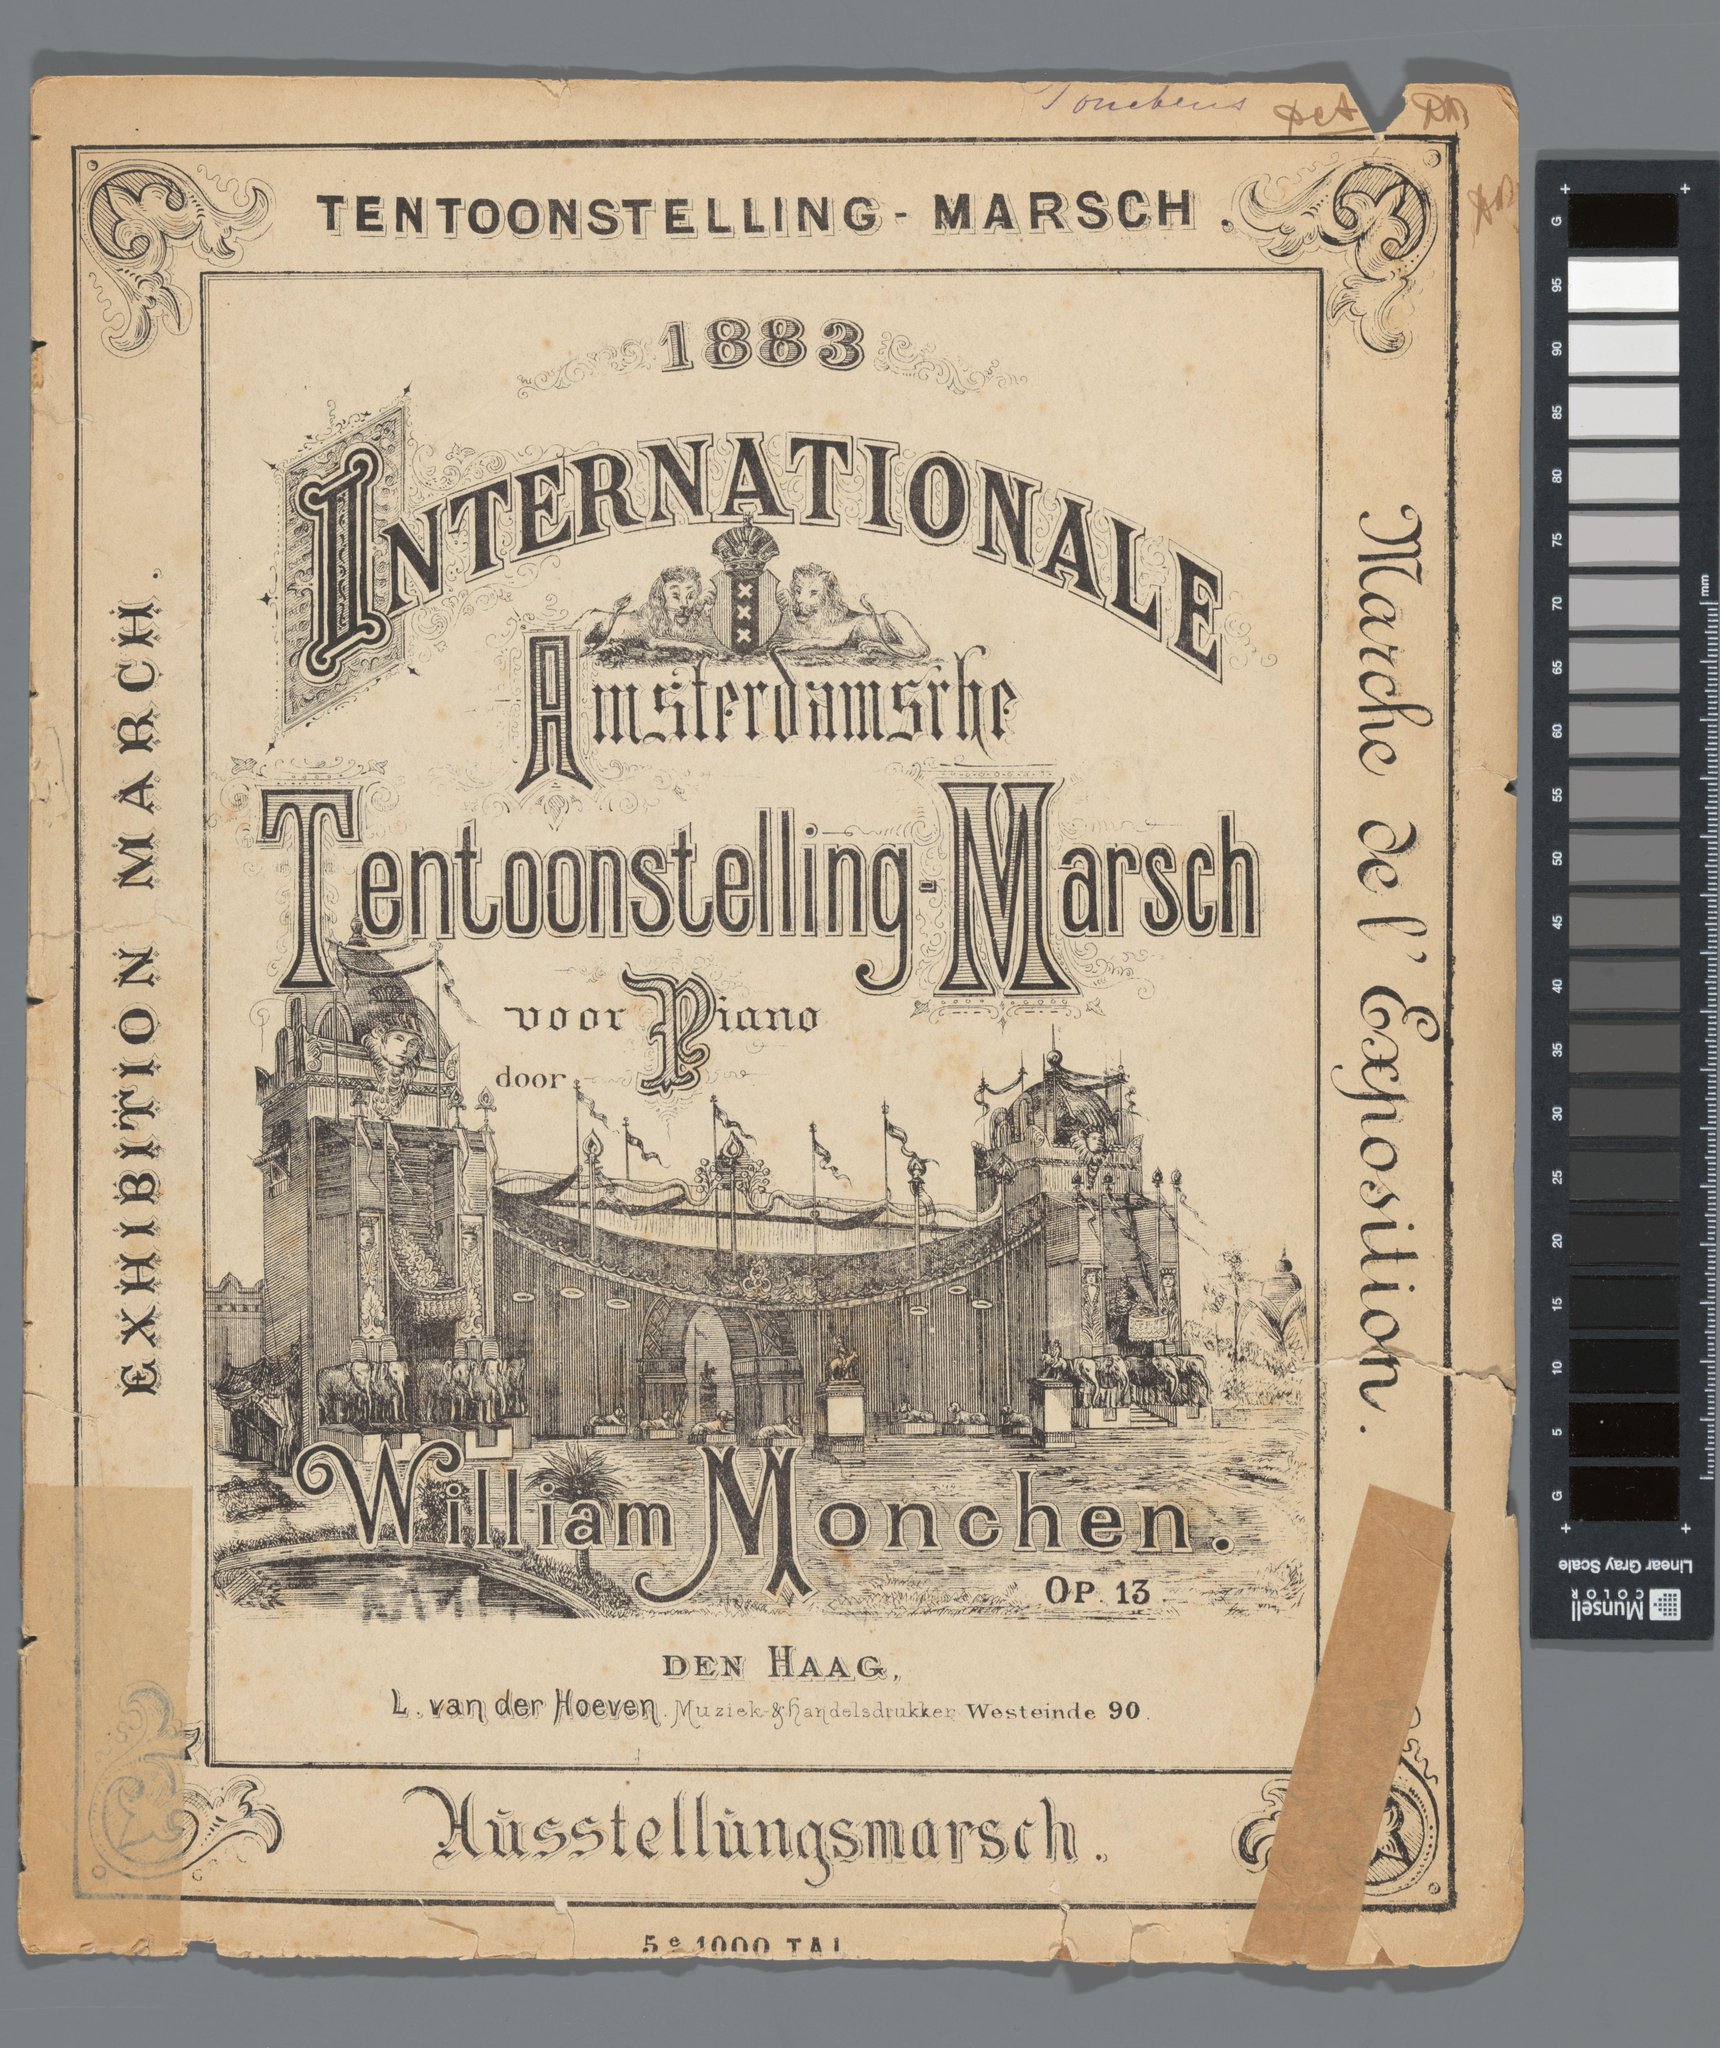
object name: sheet music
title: Internationale Amsterdamsche Tentoonstelling-Marsch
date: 1883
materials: paper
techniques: printing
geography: the hague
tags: amsterdam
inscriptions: date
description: 4 pp, bladmuziek voor piano; voorkant: exotisch bouwwerk, binnenzijde: bladmuziek, achterkant: advertenties. Gedateerd: voorpagina. Gemaakt ter gelegenheid van de Wereldtentoonstelling die in 1883 in Amsterdam werd gehouden.